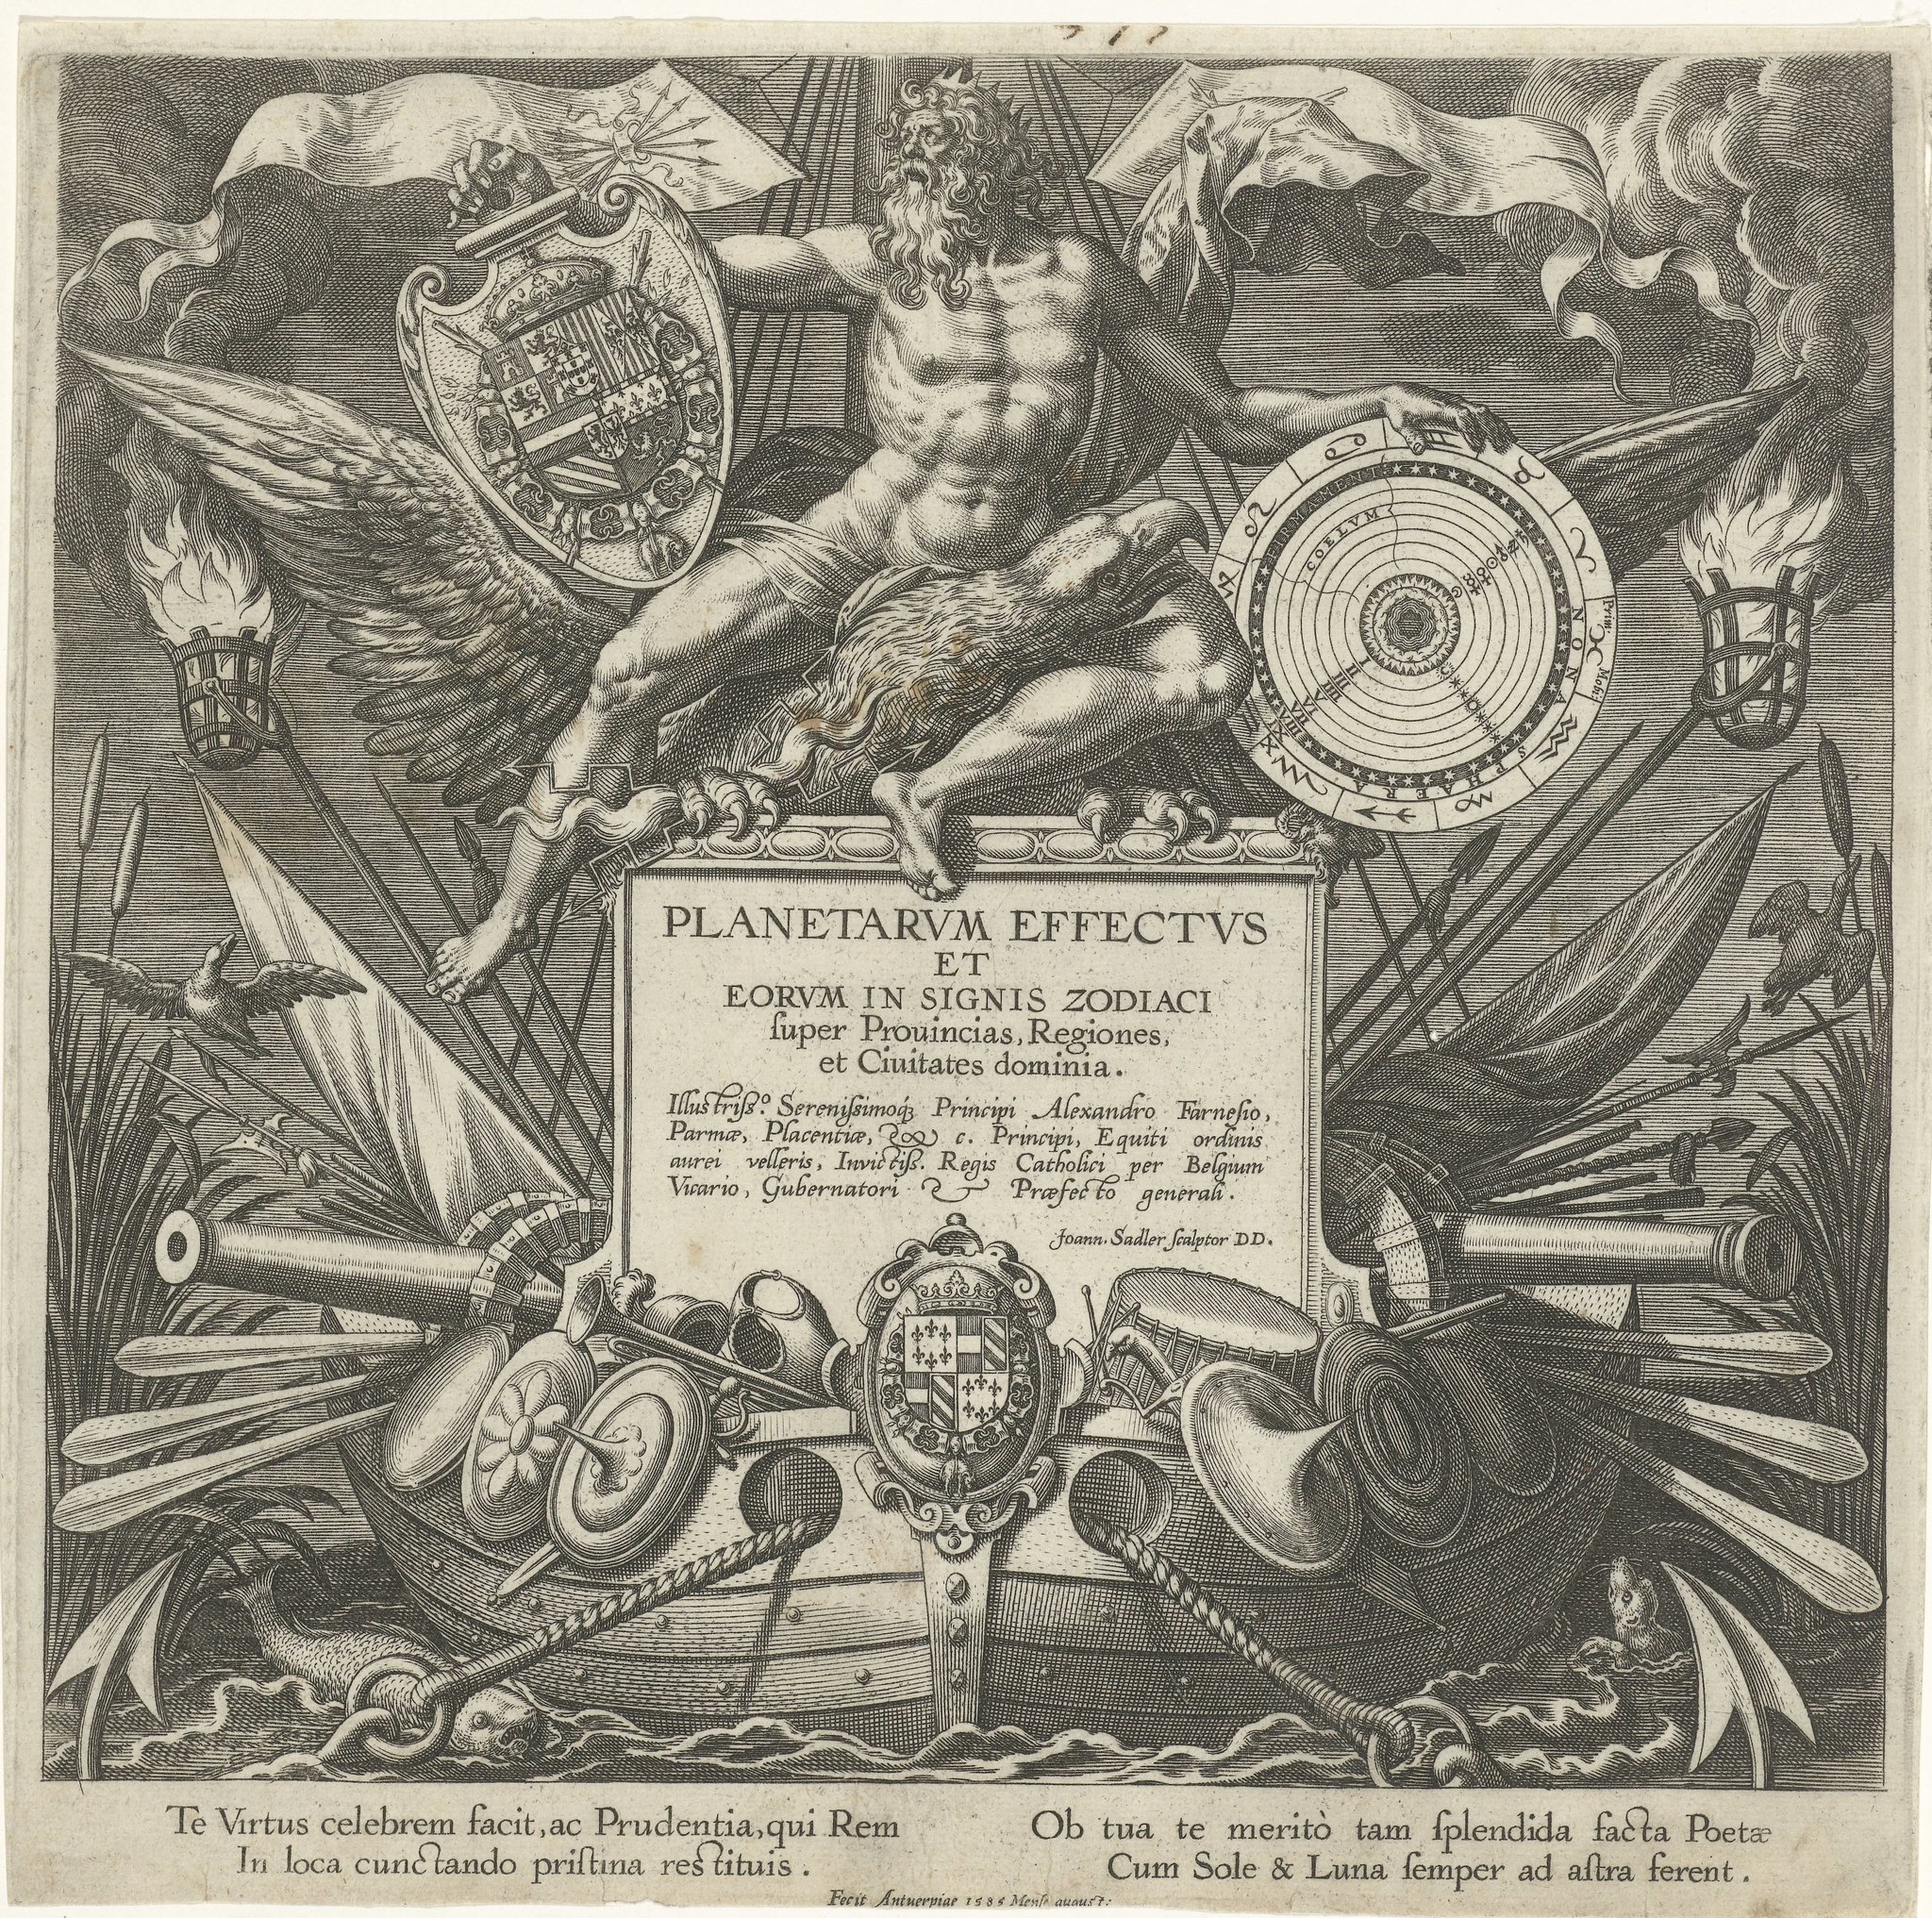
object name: titelprent, frontispice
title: Titelprent van een prentserie over de invloed van de planeten over streken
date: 1585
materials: paper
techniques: engraving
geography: antwerp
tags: philip ii of spain, rome, alessandro farnese (landvoogd van de nederlanden en hertog van parma en piacenza), mankind influenced by the planets, including sun and moon; 'planetenkinder', (story of) jupiter (zeus), title-page, ships (in general), firearms: cannon, star-chart, star map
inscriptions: collector's mark: Lugt 2228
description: Een oorlogsschip, versierd met de wapens van Alessandro Farnese. Op de boot een sokkel met de titel van de prentserie. Op de sokkel zit Jupiter met zijn adelaar, het wapenschild van Filips II en een hemelkaart in de handen. De titelprent van een prentserie over de invloed van de planeten over streken. In de marge een Latijns lofdicht.